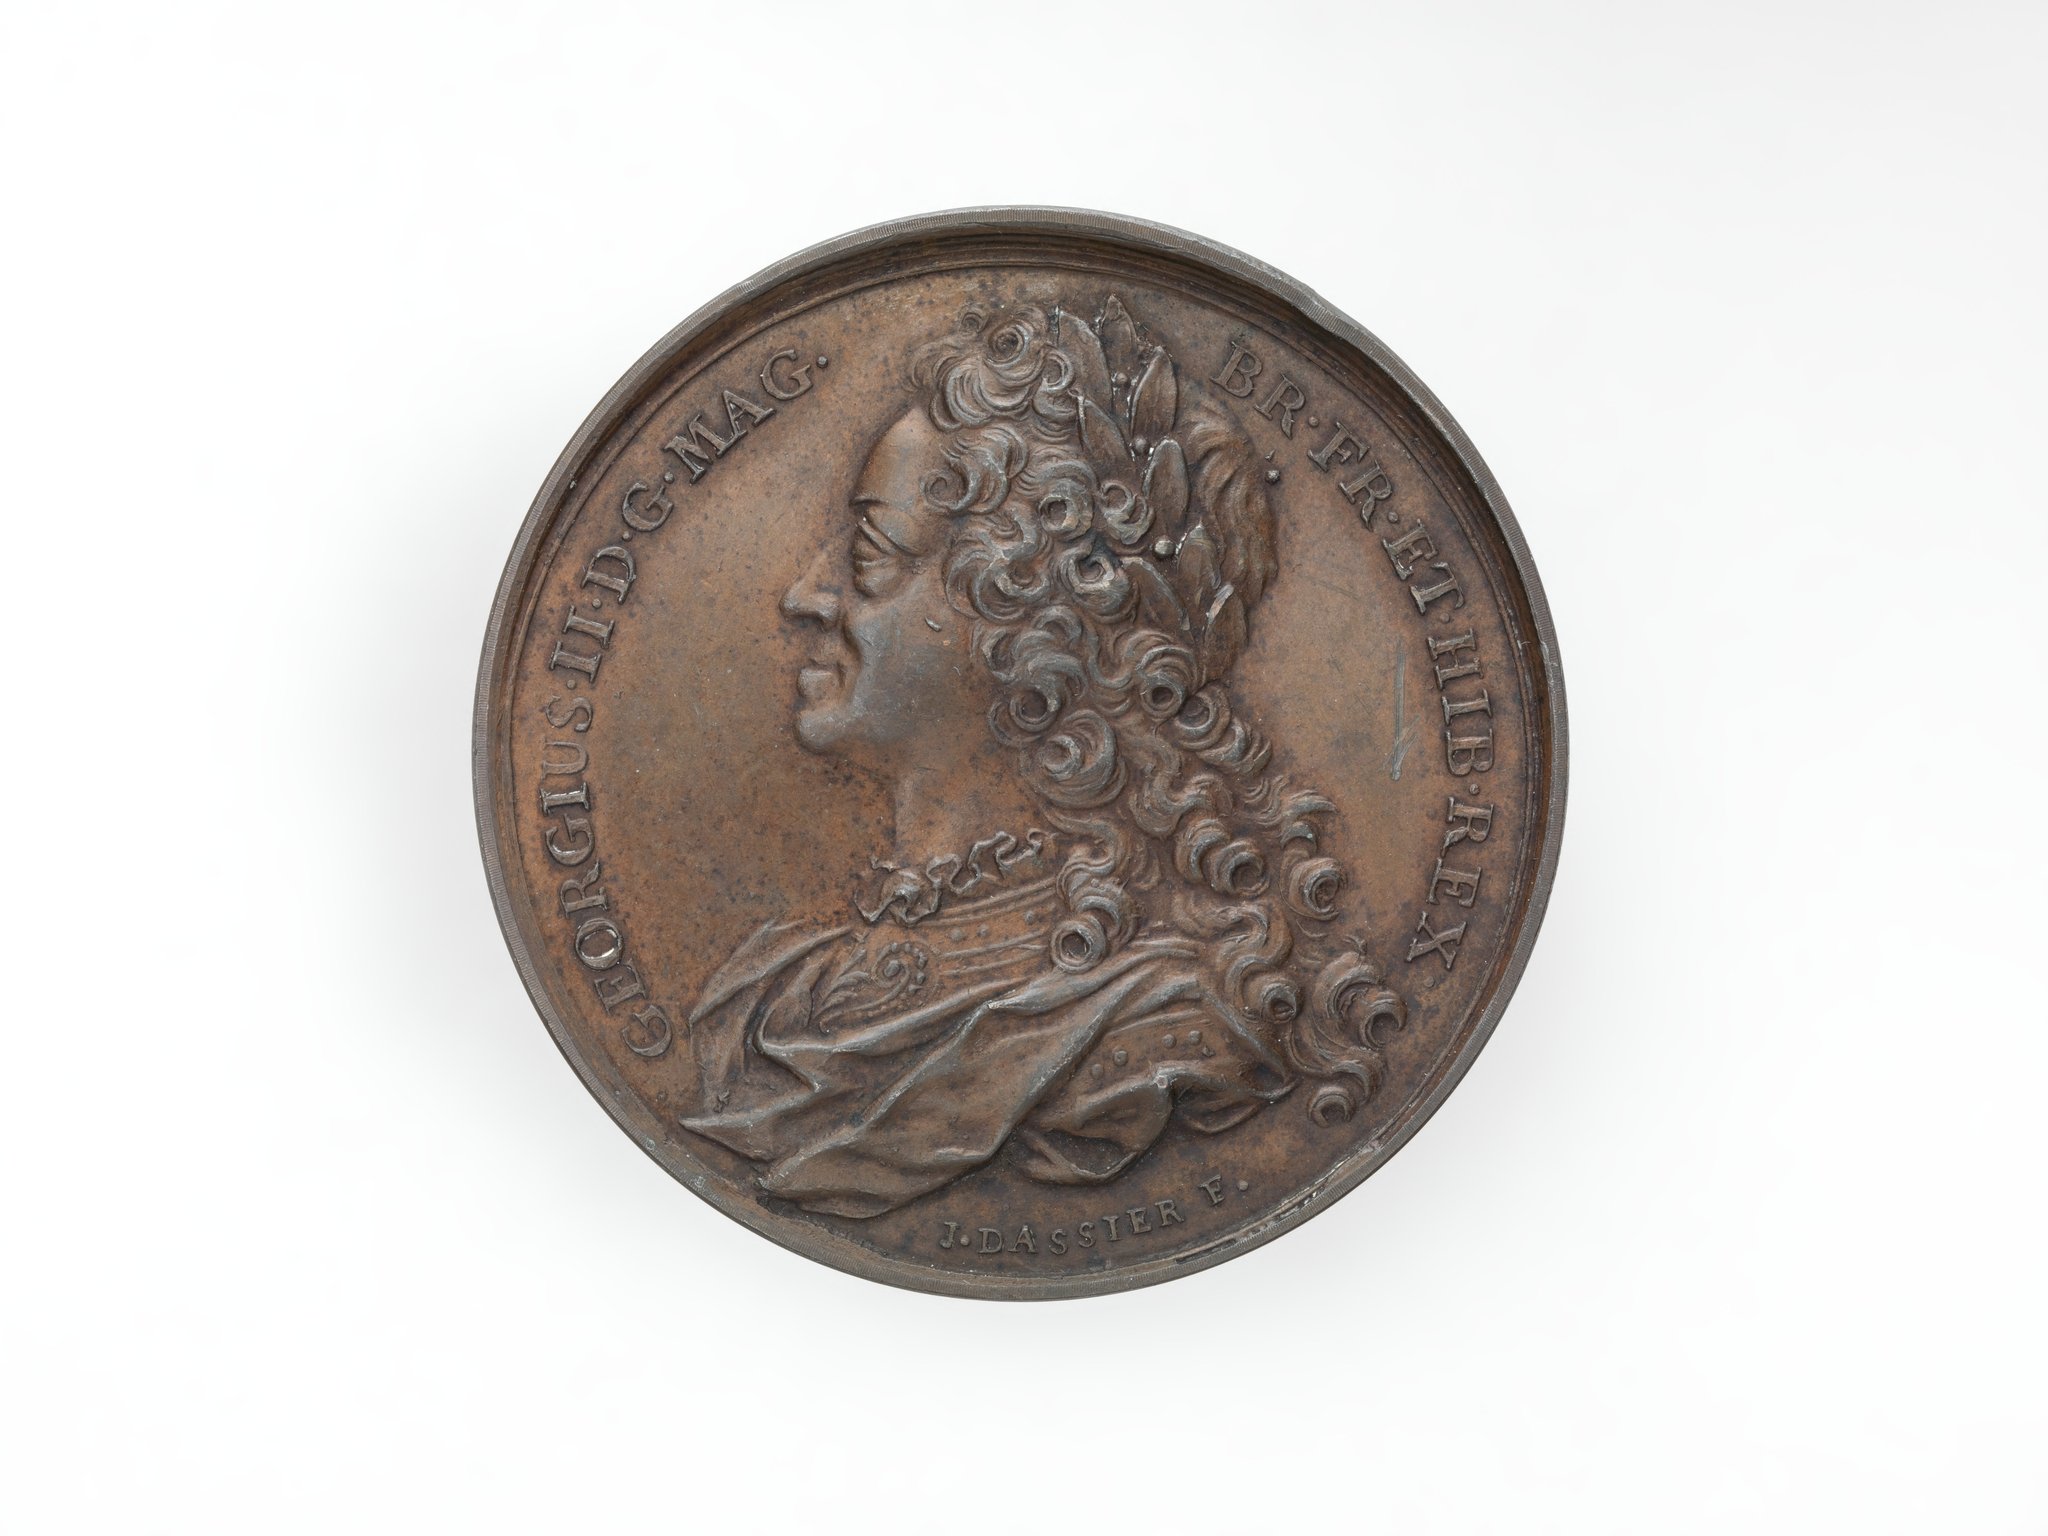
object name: medal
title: George II, from the English Monarchs series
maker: jean dassier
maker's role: artist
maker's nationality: swiss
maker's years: 1676-1763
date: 1731-1732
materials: bronze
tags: kings,profiles